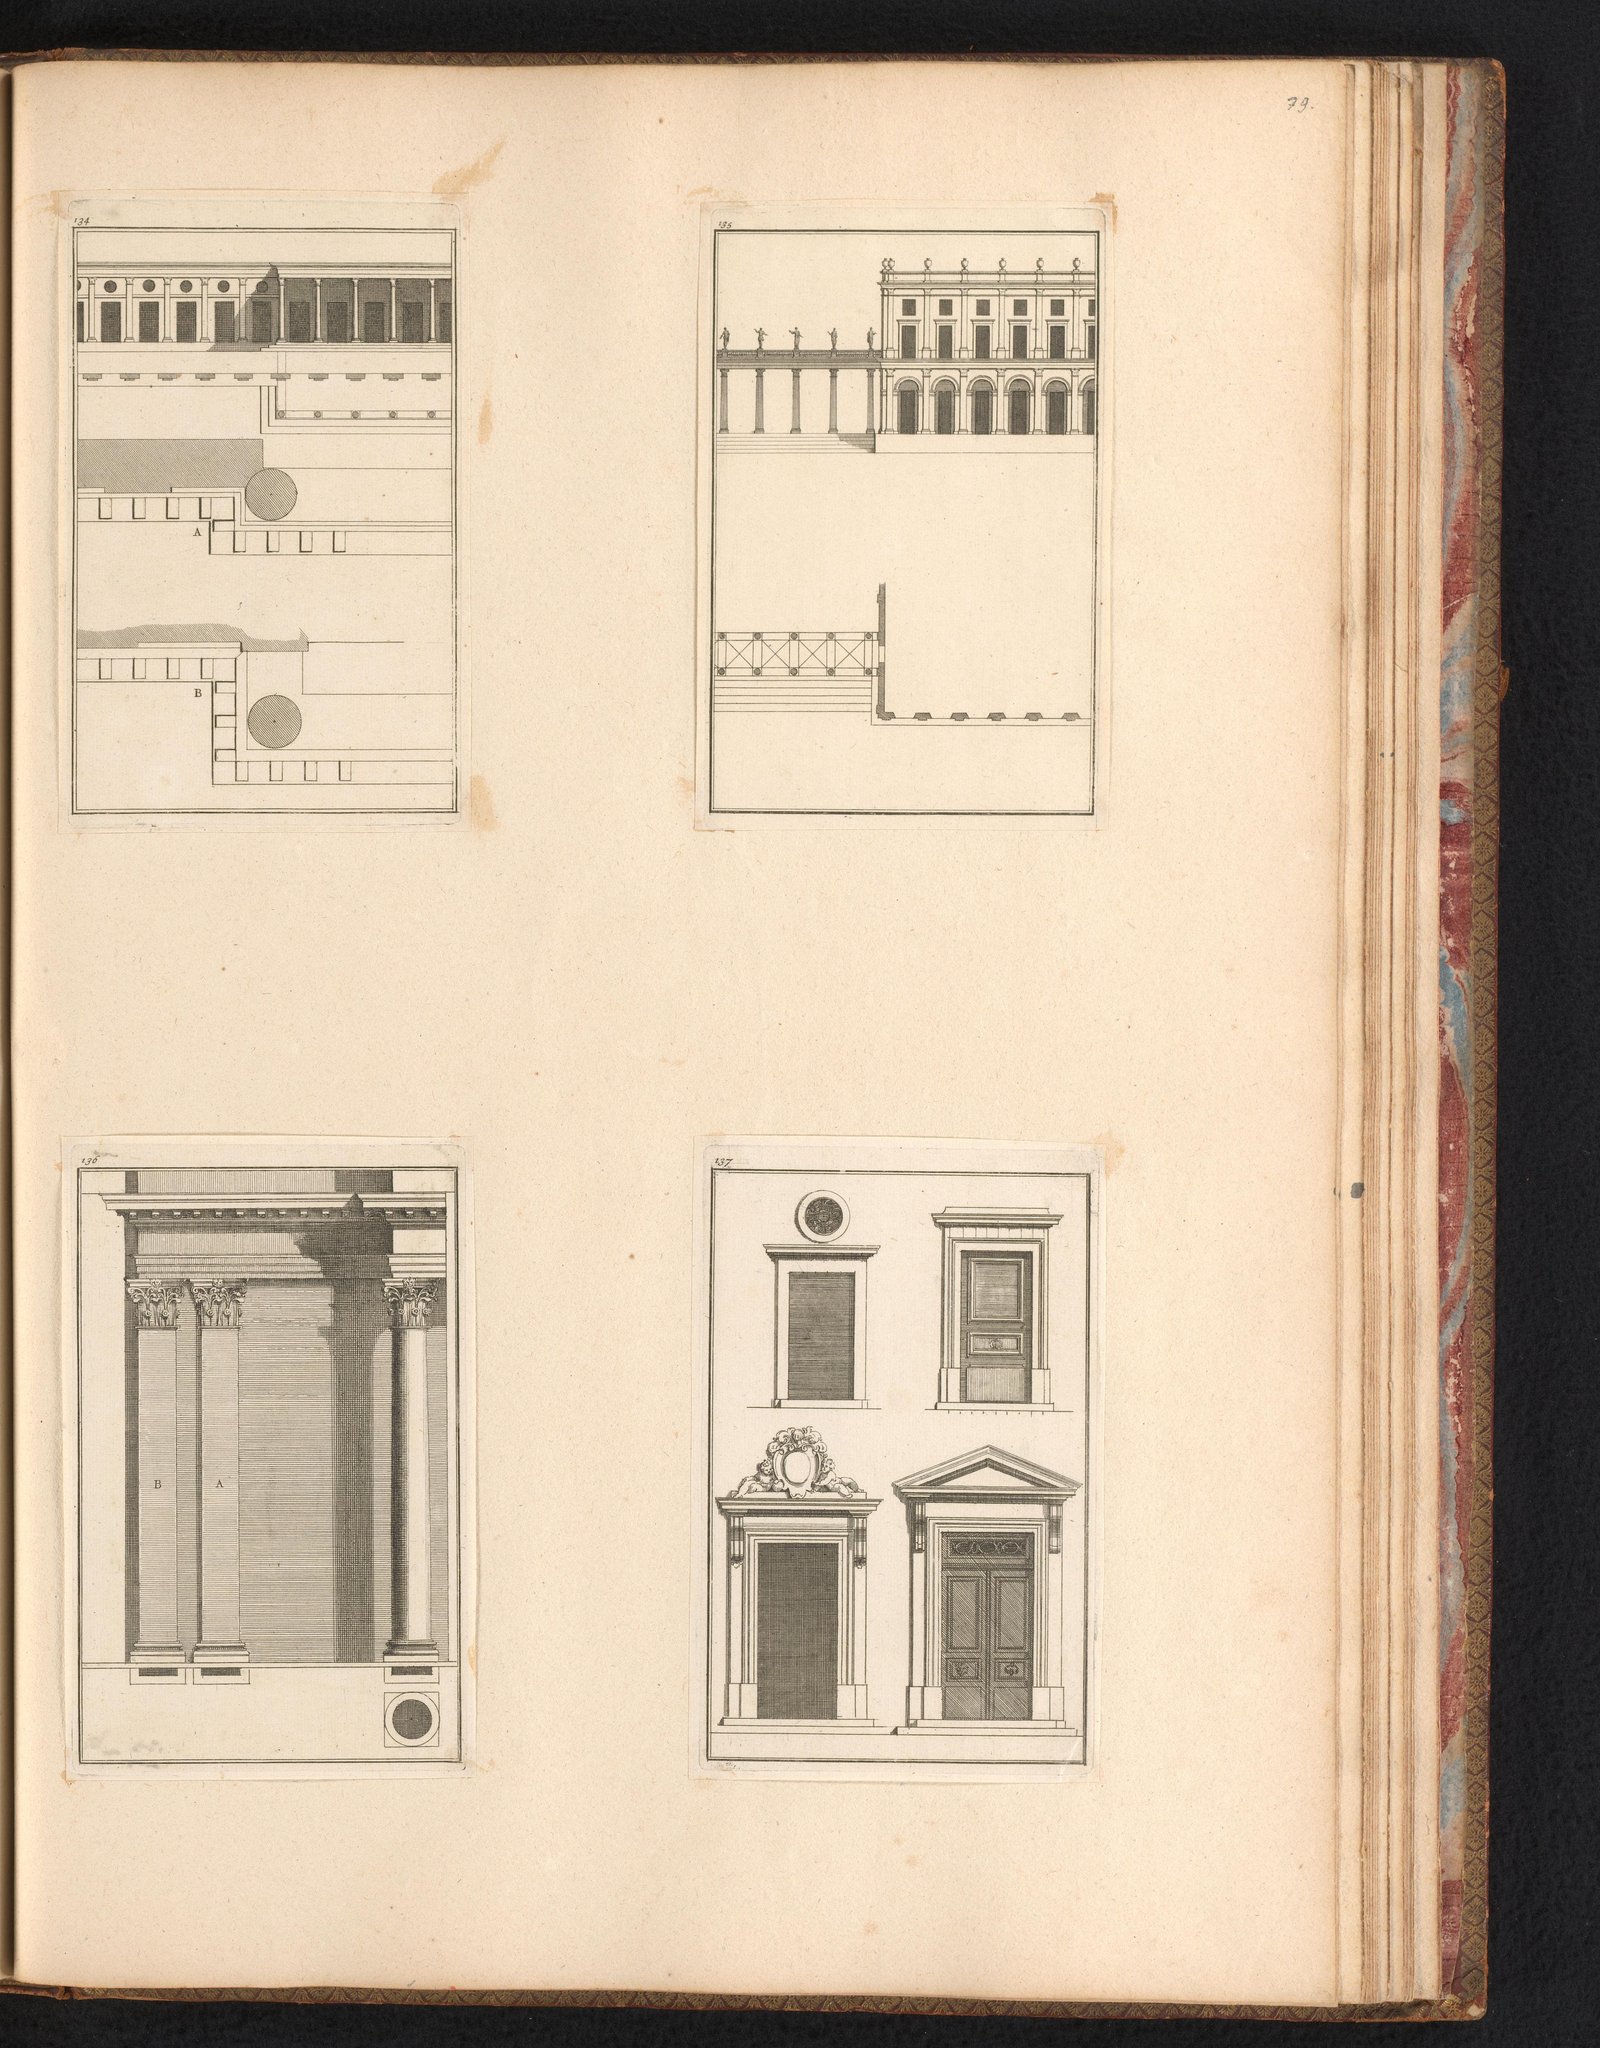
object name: album leaf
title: Klassieke architecturale elementen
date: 1714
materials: paper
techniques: etching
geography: paris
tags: colonnade, orders, order-books ~ architecture, door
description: Prenten uit: Leclerc, Sébastien (I). Traité d'architecture. Parijs: Pierre François Giffart, 1714.